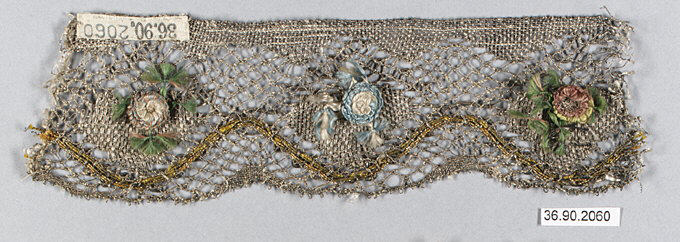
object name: passementerie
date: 1767-1800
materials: metal thread, silk